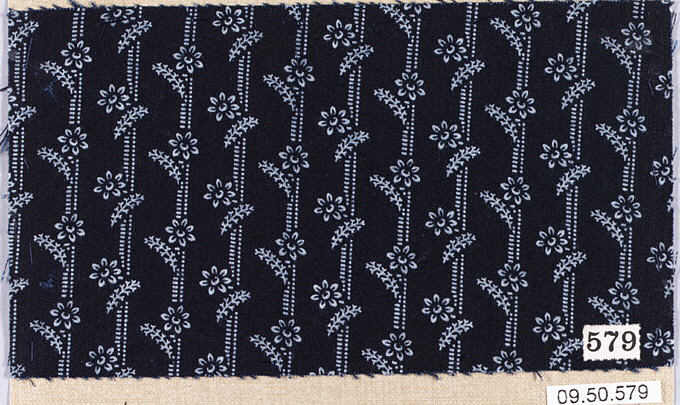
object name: piece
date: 1801-1900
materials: cotton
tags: flowers,leaves